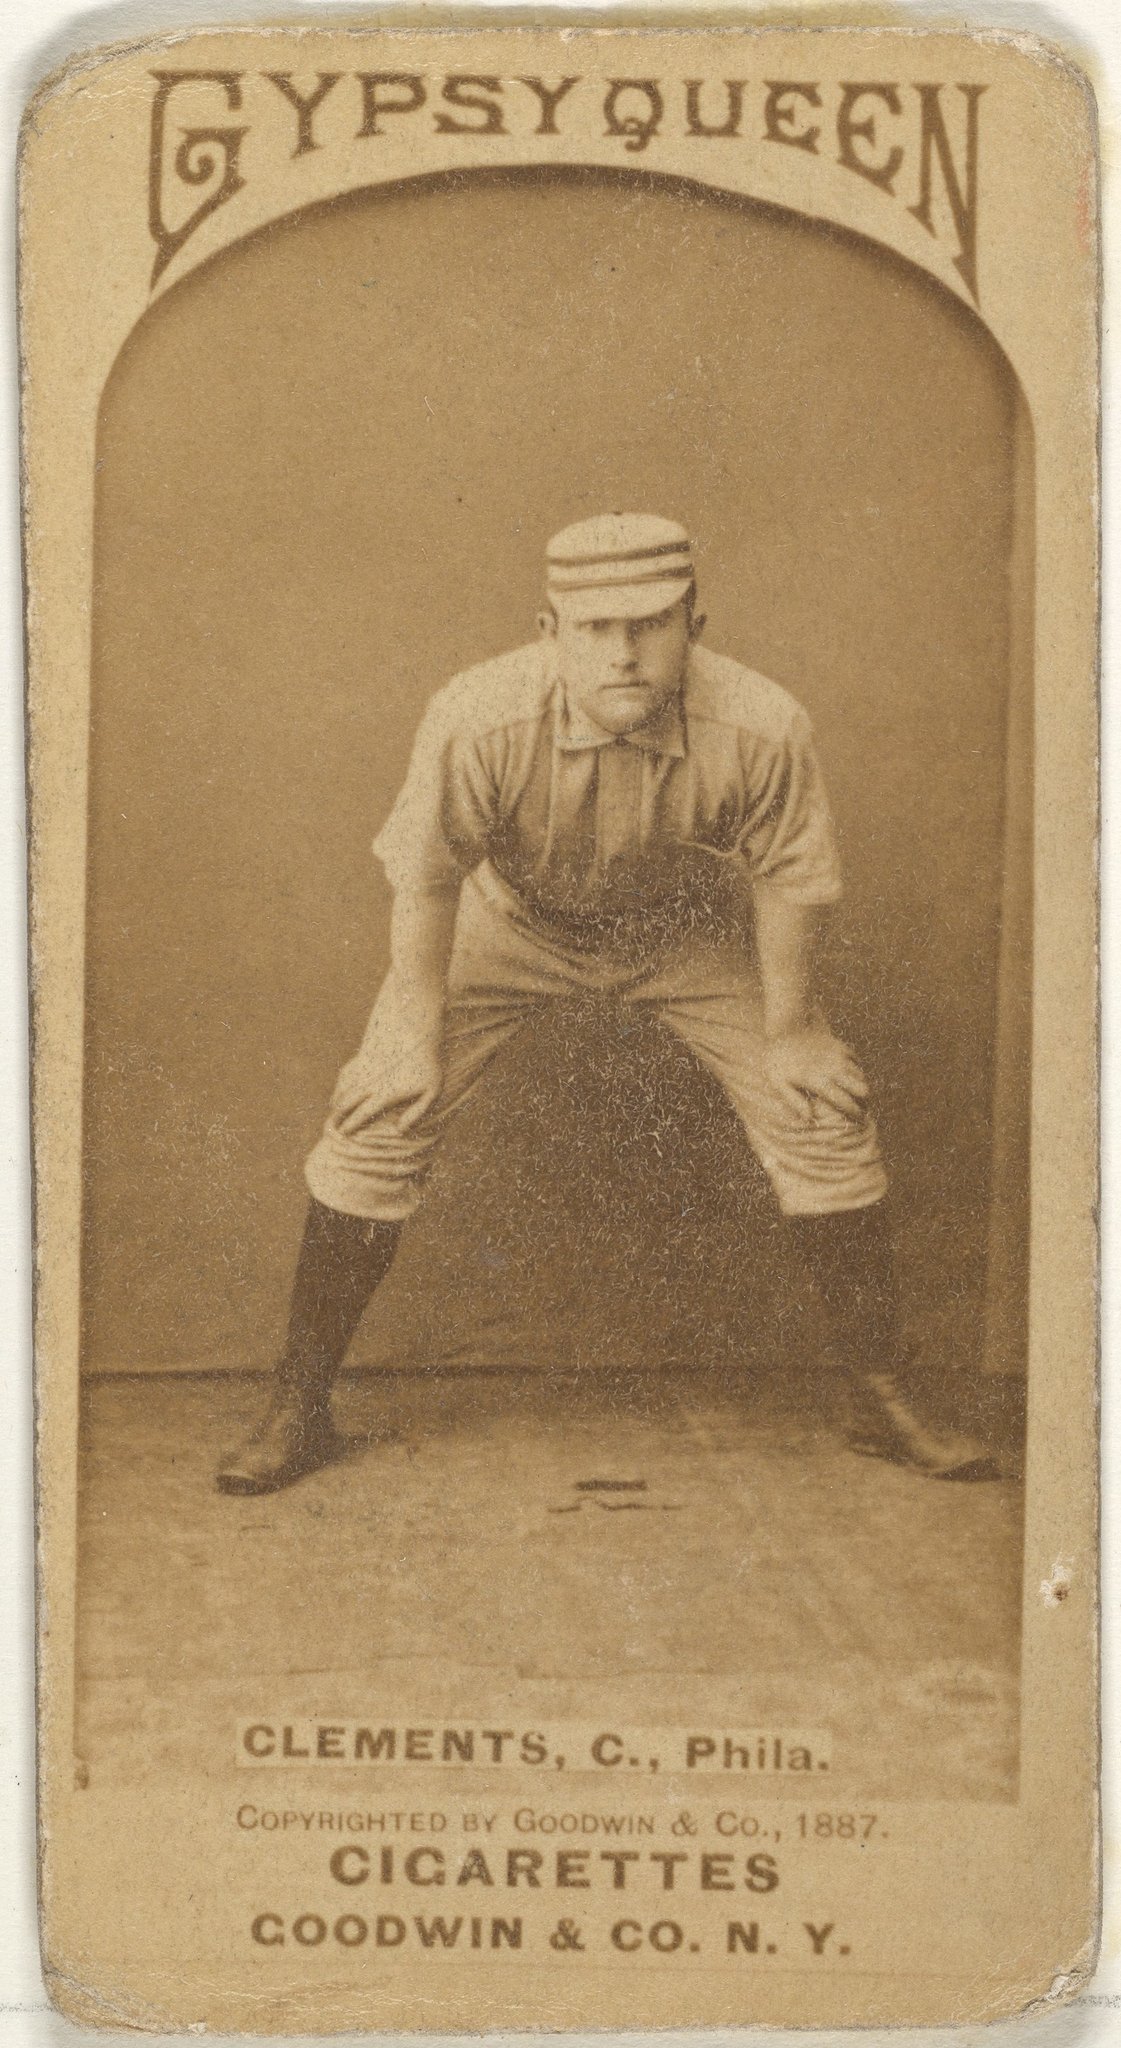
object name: baseball card, photograph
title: John J. "Jack" Clements, Catcher, Philadelphia, from the Old Judge series (N172) for Old Judge and Gypsy Queen Cigarettes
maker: goodwin & company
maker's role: publisher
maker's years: 1850-1950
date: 1887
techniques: albumen silver print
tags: men,portraits,baseball,athletes